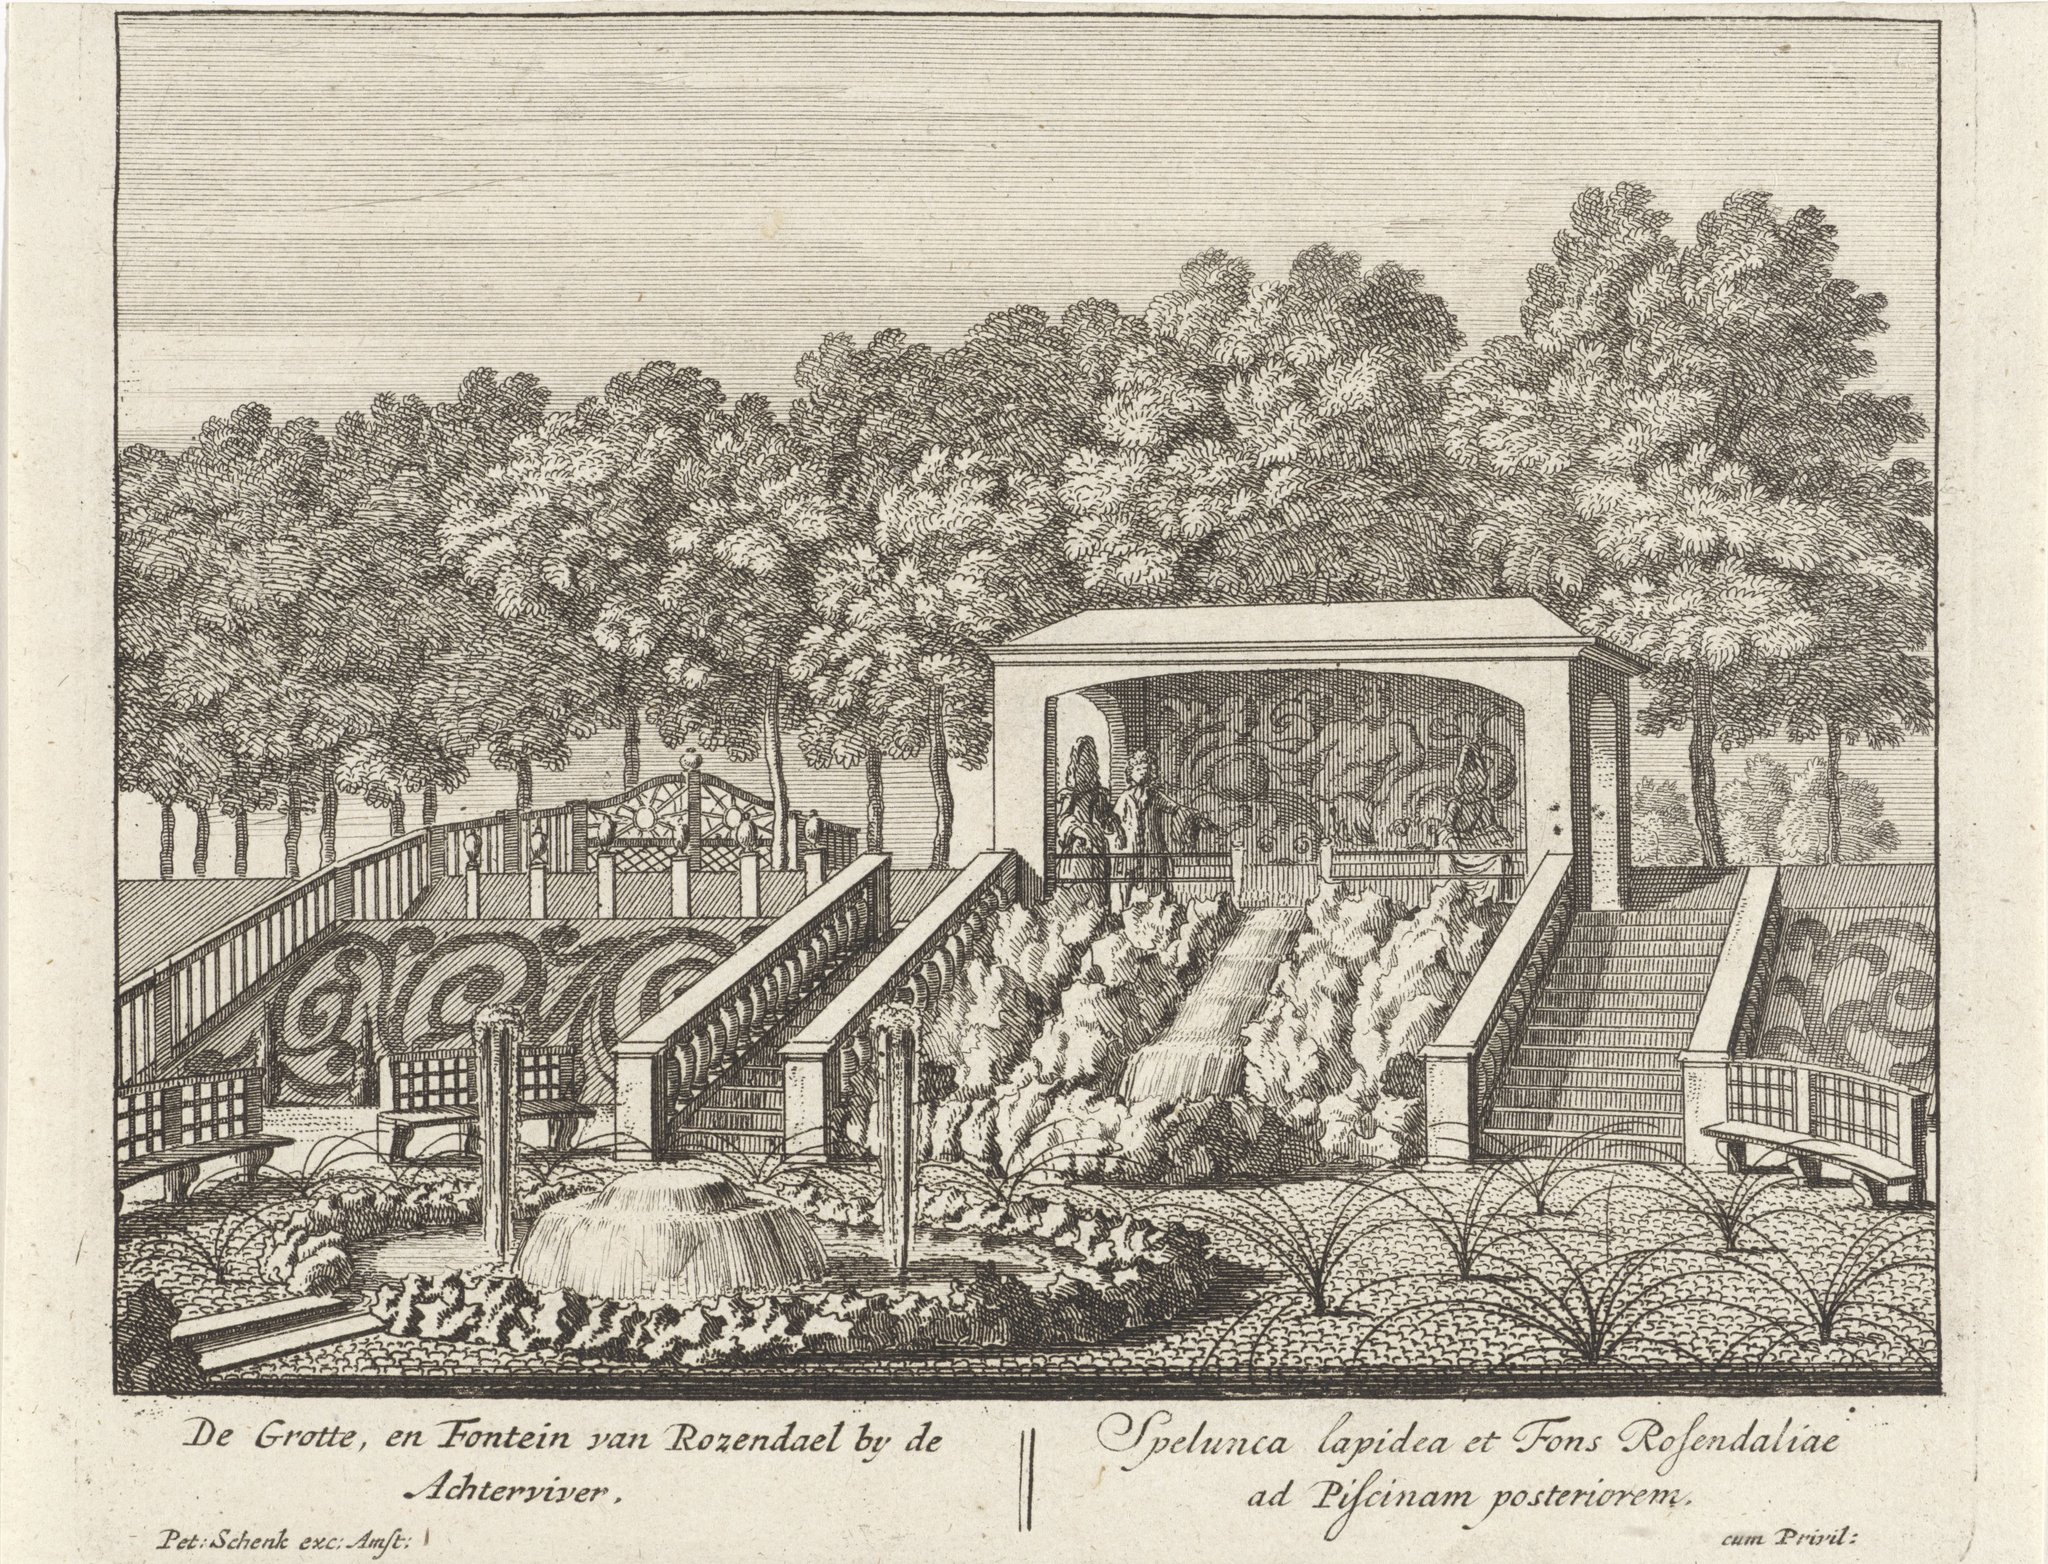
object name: print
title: Gezichten op Kasteel Rosendael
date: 1675-1711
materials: paper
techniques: etching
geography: amsterdam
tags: garden fountain, cave, grotto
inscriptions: collector's mark: Lugt 2228